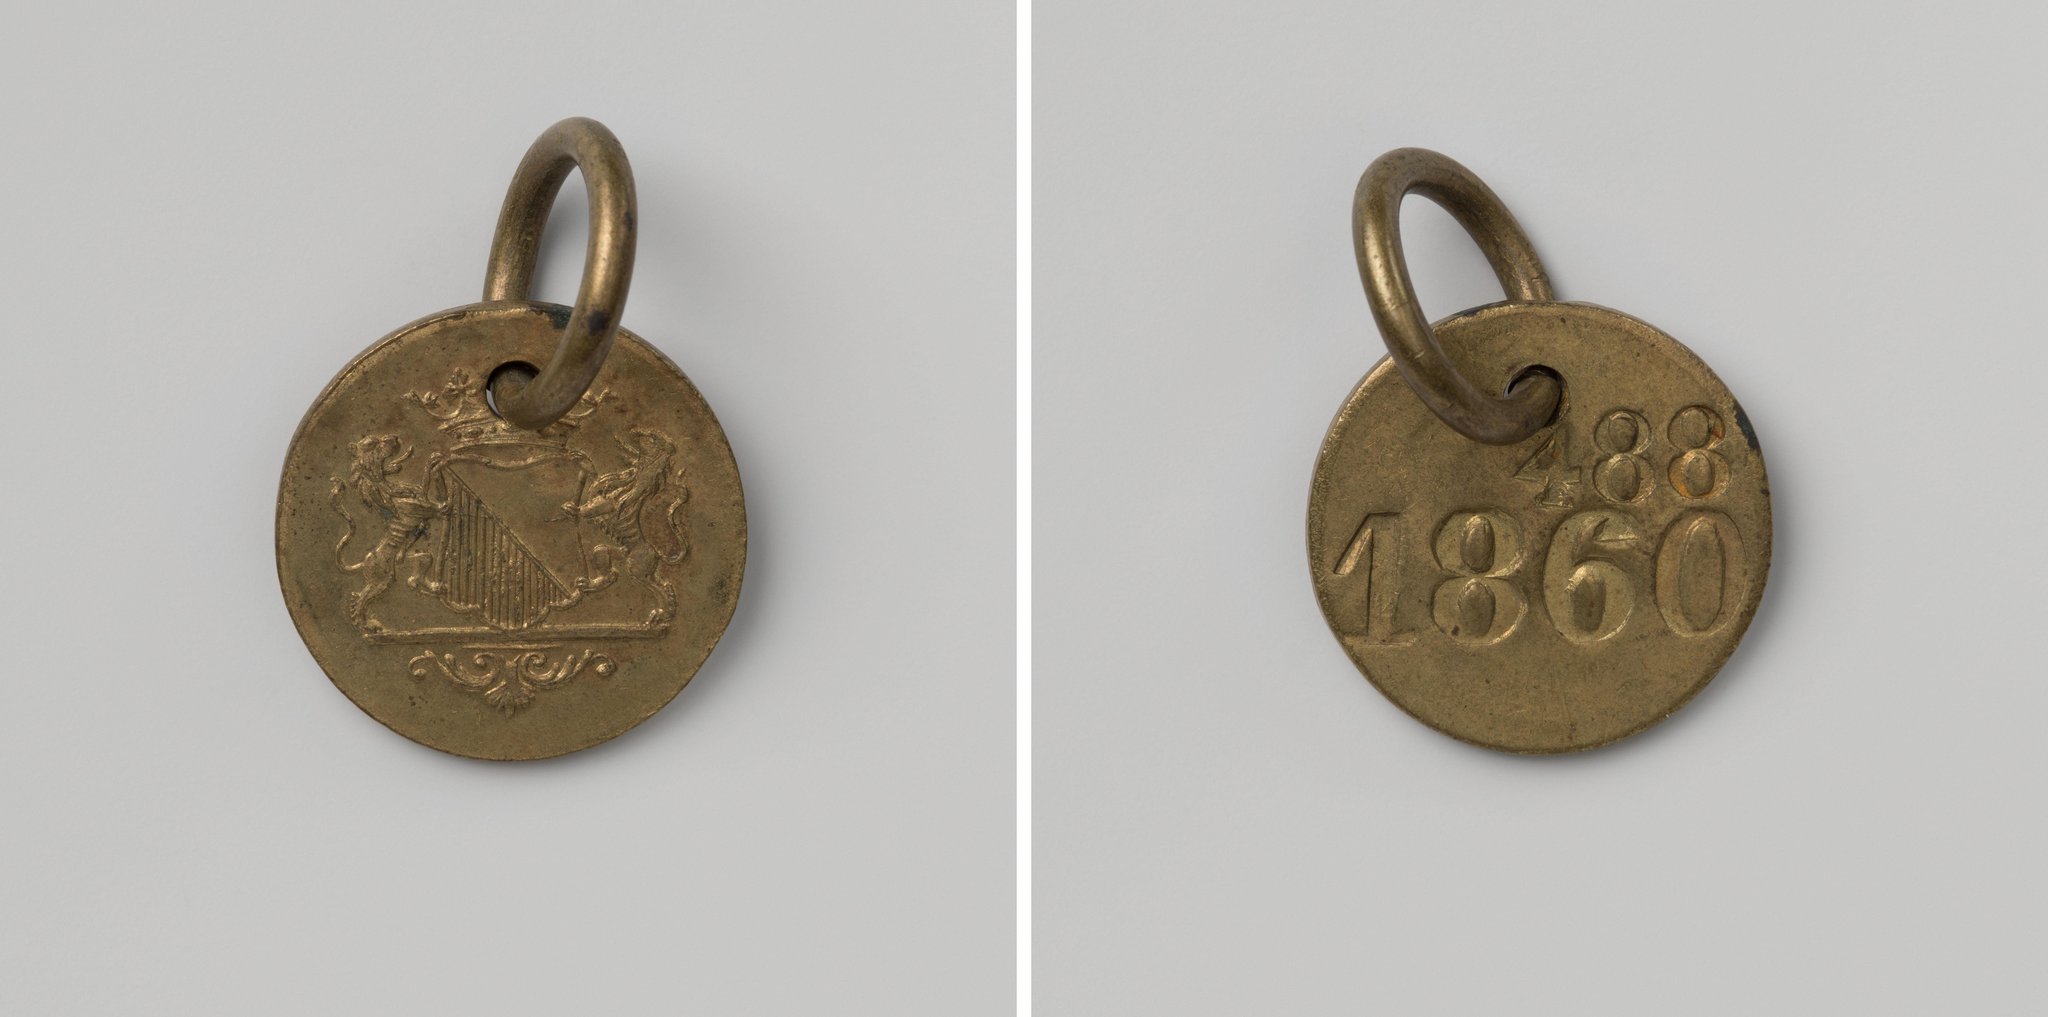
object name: tax token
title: Stad Utrecht, loodje met no. 488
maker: Anonymous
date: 1860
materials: brass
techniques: striking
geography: utrecht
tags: utrecht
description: loodje met gat erin aan draagring. Voorzijde: cijfer 488 boven jaartal. Keerzijde: gekroond wapenschild, geflankeerd door twee leeuwen